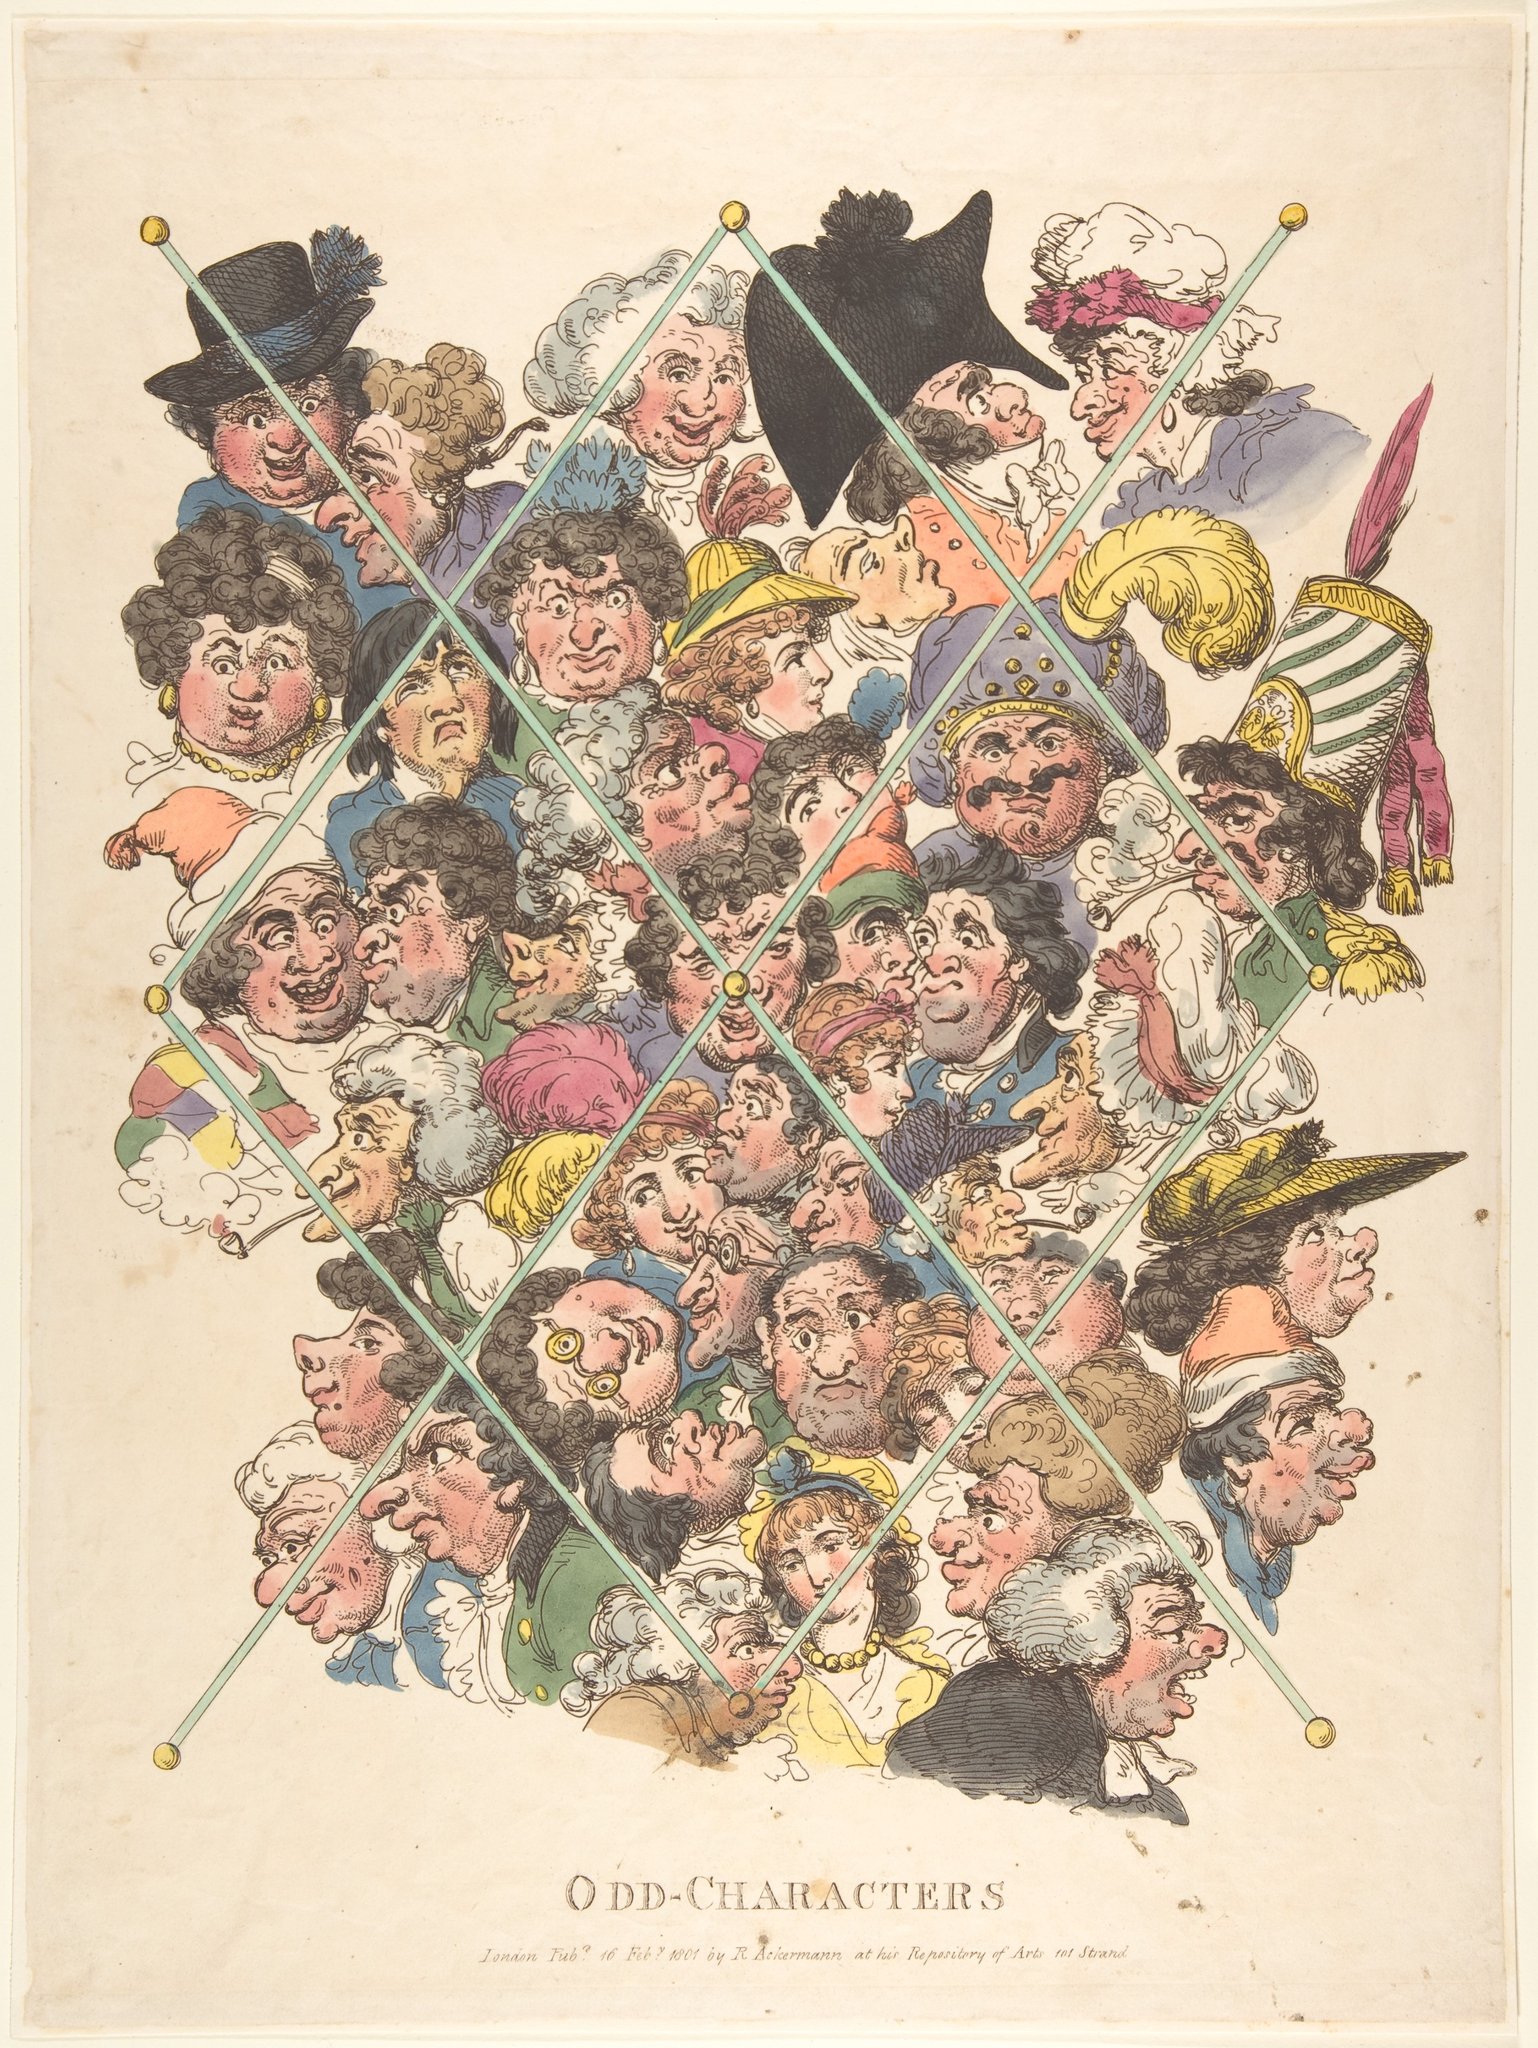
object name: print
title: Odd Characters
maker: thomas rowlandson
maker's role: artist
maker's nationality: british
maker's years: 1757-1827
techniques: etching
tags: satire,heads,men,women